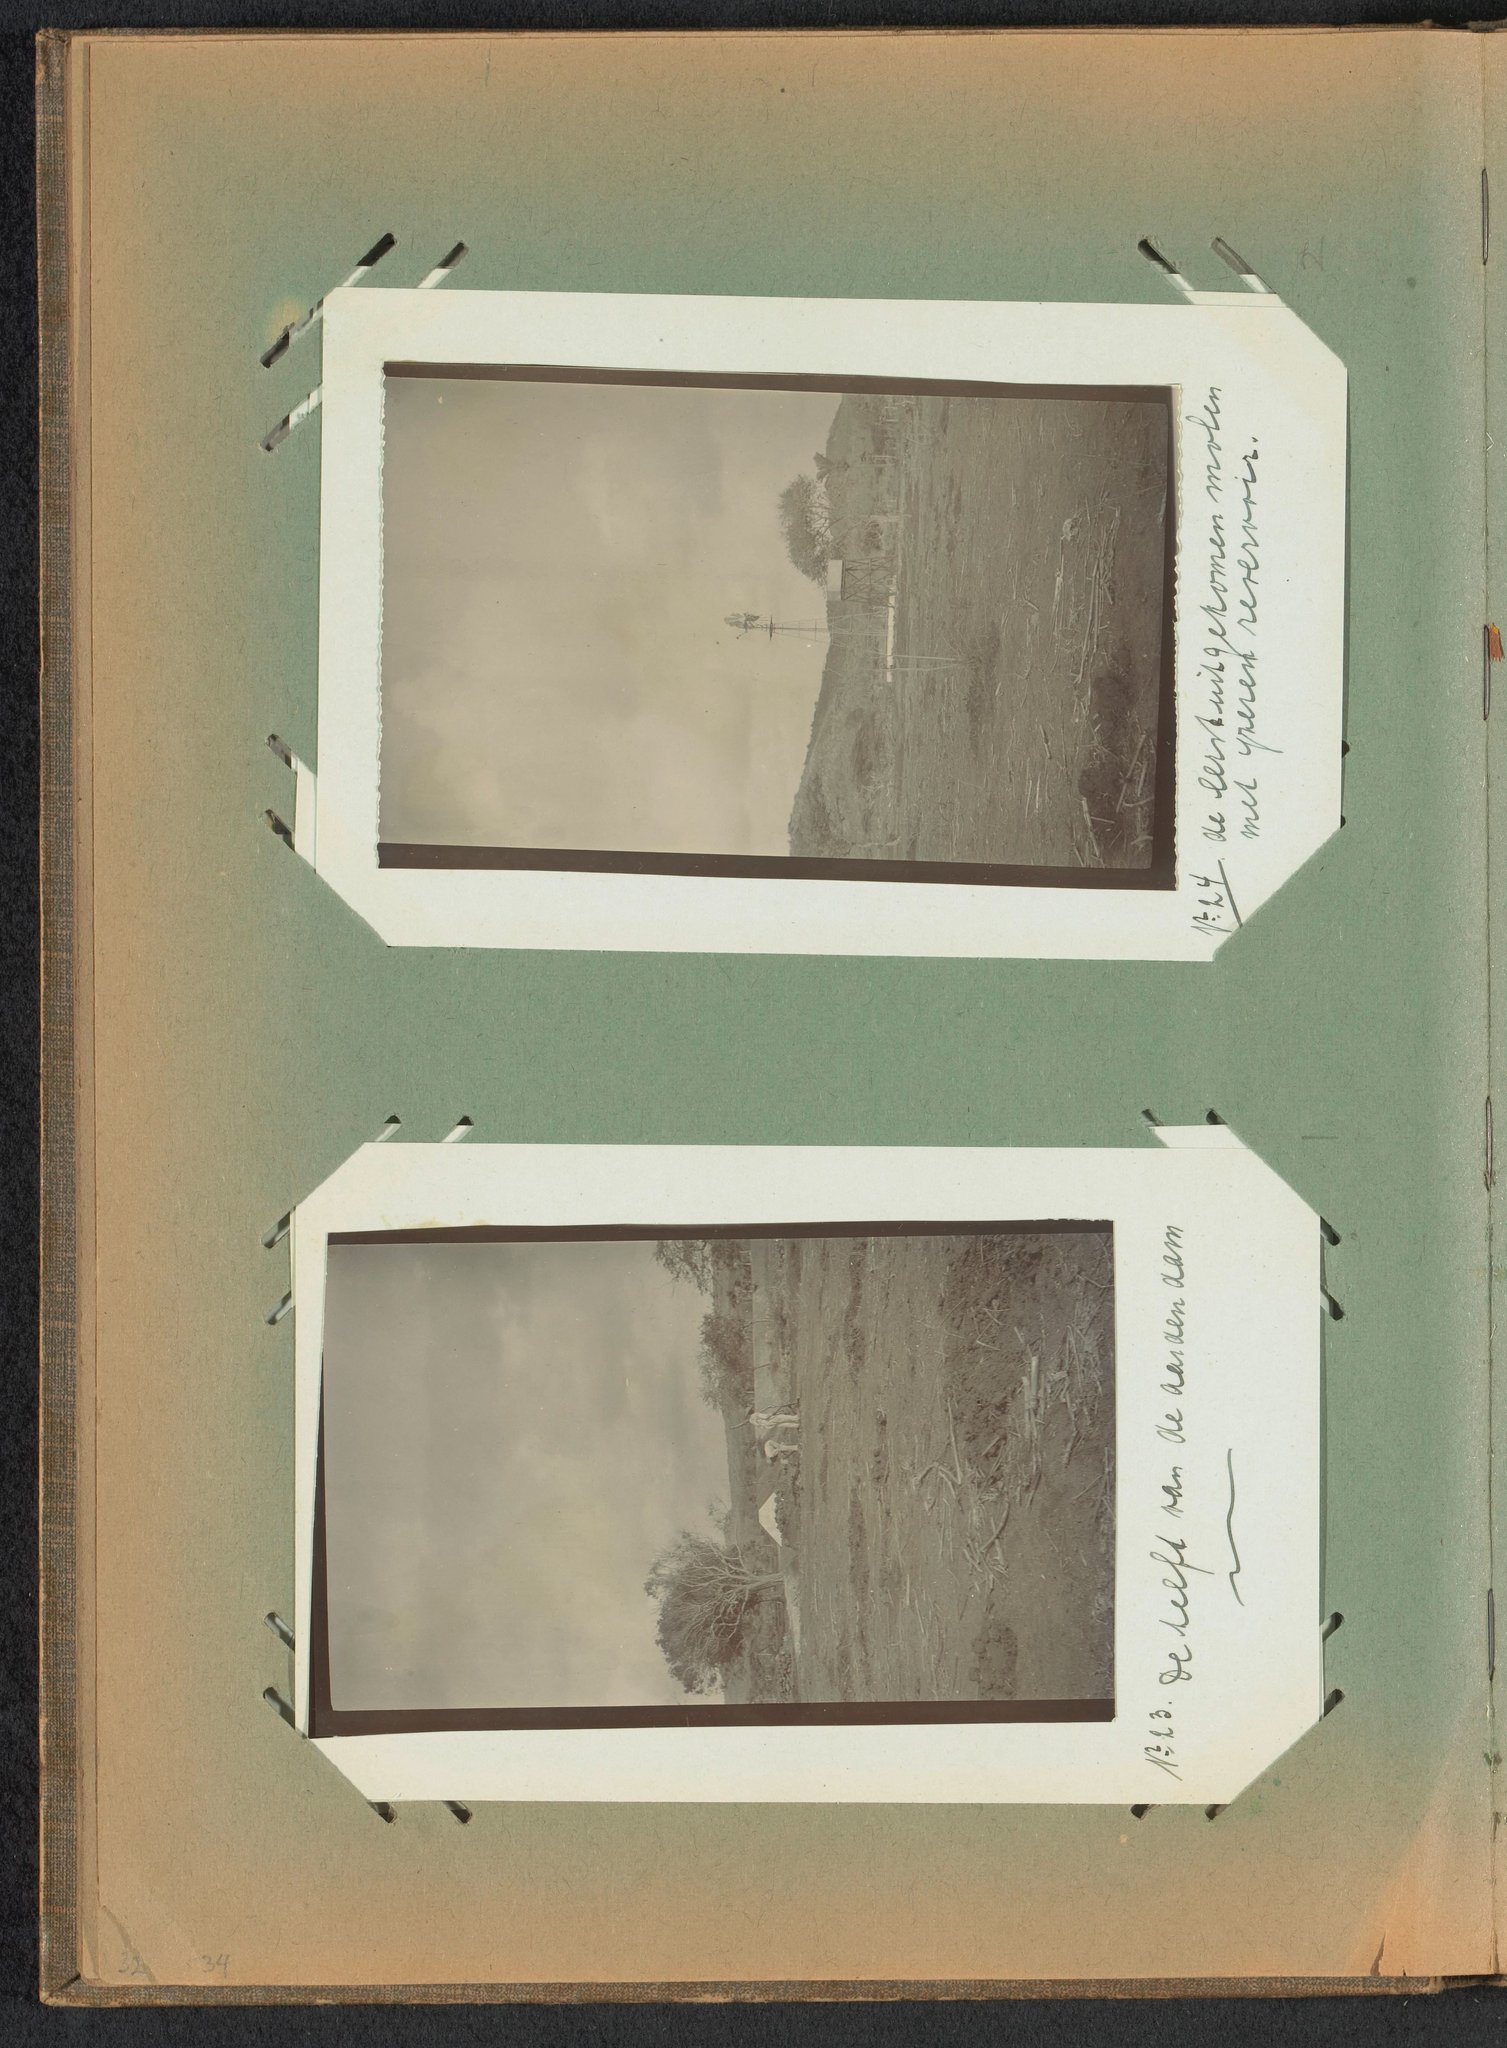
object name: photograph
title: Nr. 23 De helft van de aarden dam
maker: Anonymous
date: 1912-1913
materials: paper, photographic support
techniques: gelatin silver print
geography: curacao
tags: plantation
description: Bouw van een dam. Bij Plantage Mount Pleasant op Curaçao. Onderdeel van het fotoalbum uit ca. 1912-1913 met 92 foto's van de plantages Peperpot en Dordrecht in Suriname en Mount Pleasant op Curaçao.